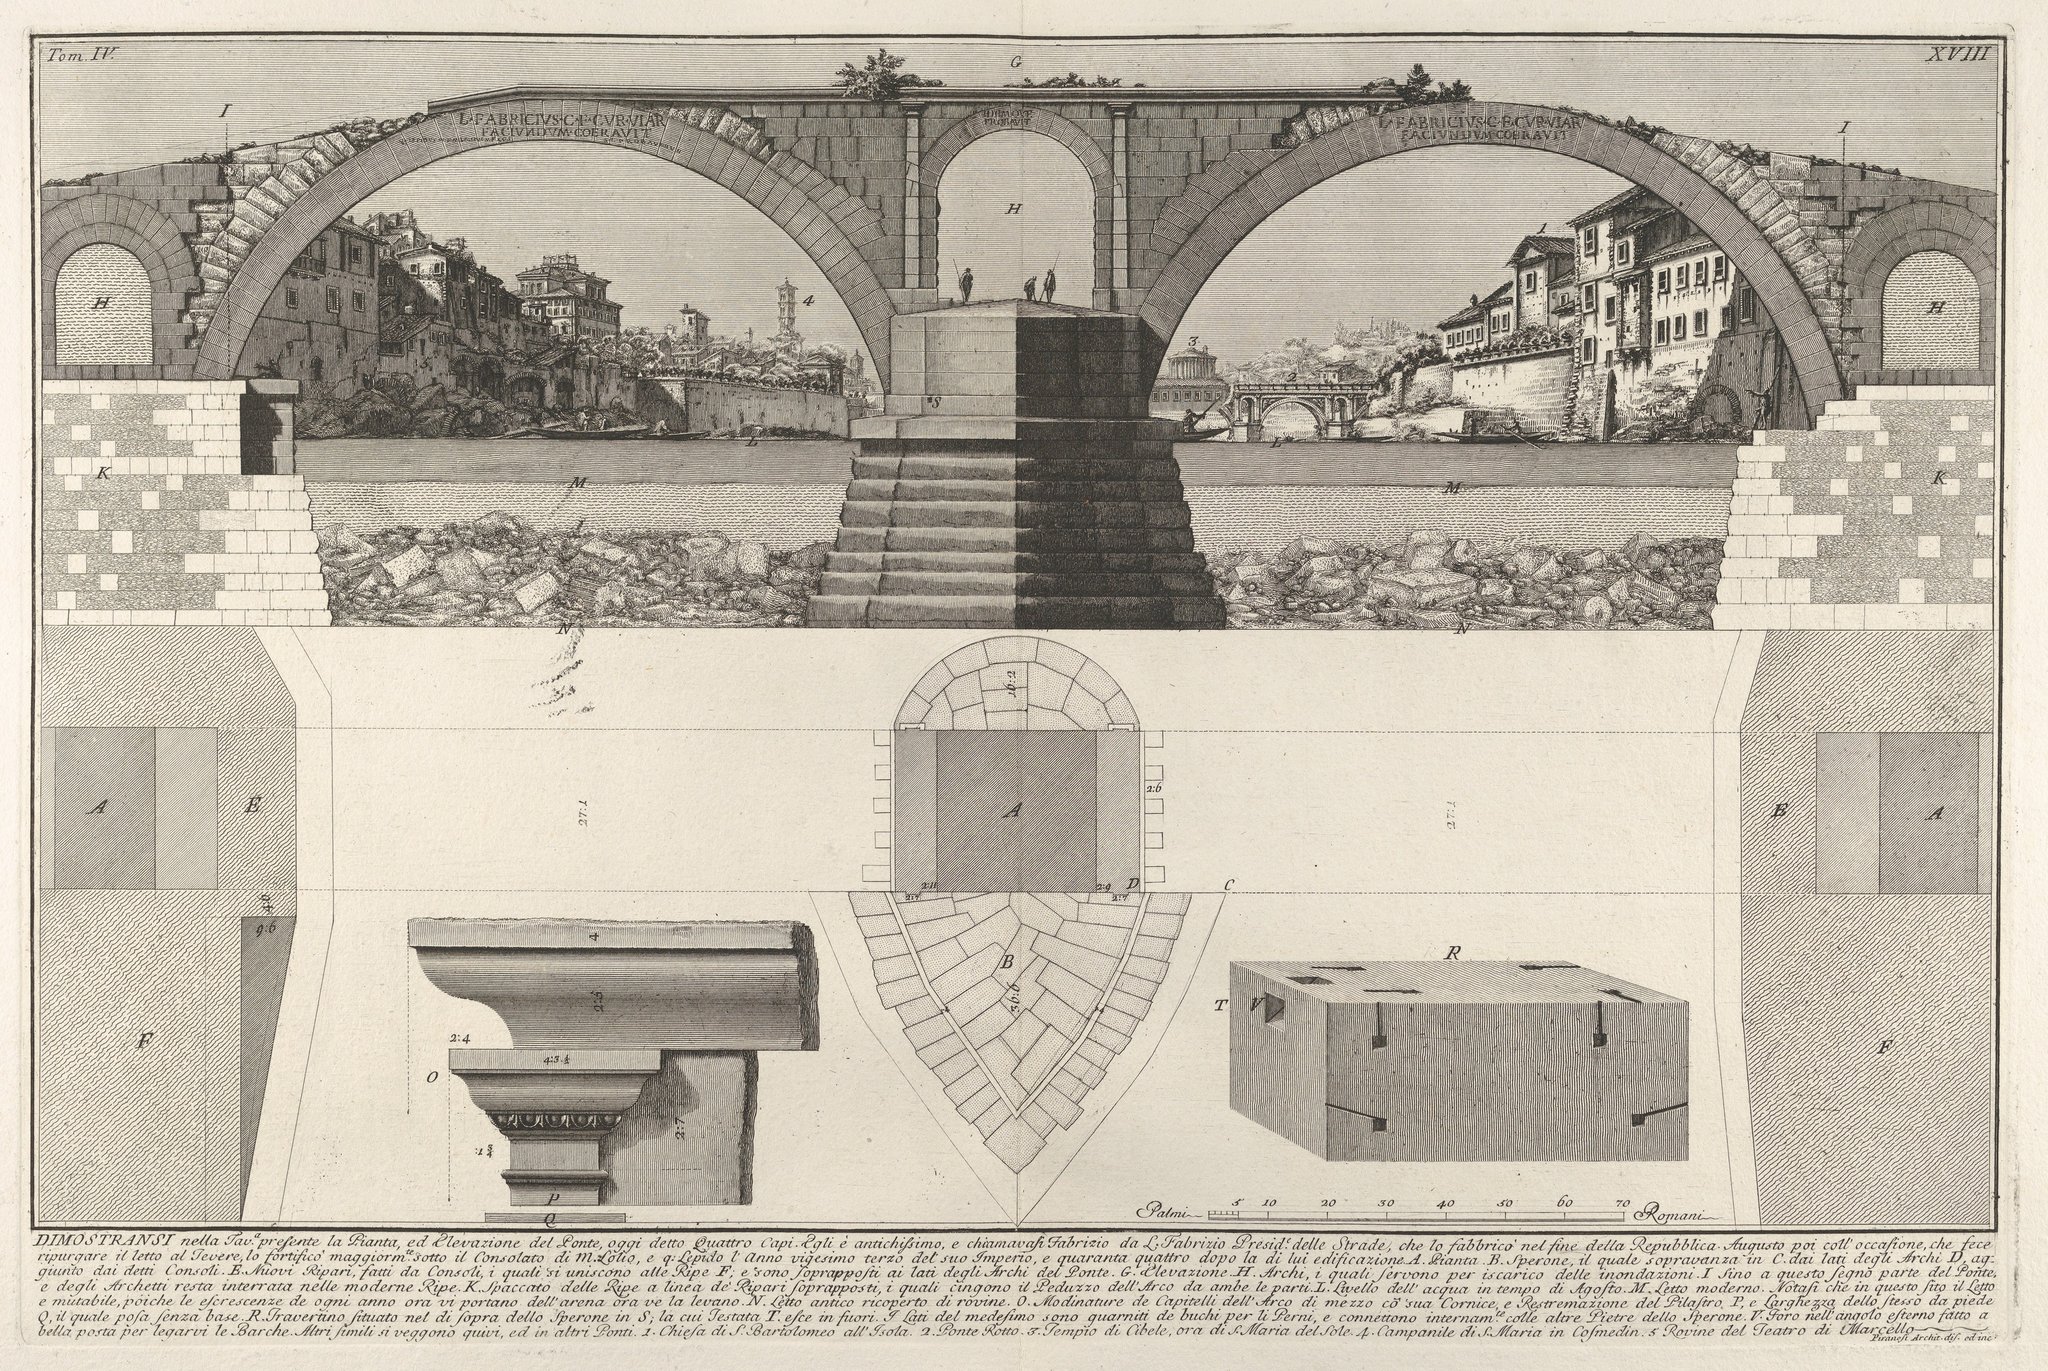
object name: print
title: Plan and elevation of the Pons Fabricius (also known as the Quattro Capi Bridge), Rome, from "Le Antichità Romane"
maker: giovanni battista piranesi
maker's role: artist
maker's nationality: italian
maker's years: 1720-1778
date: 1756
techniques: etching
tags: architecture,bridges